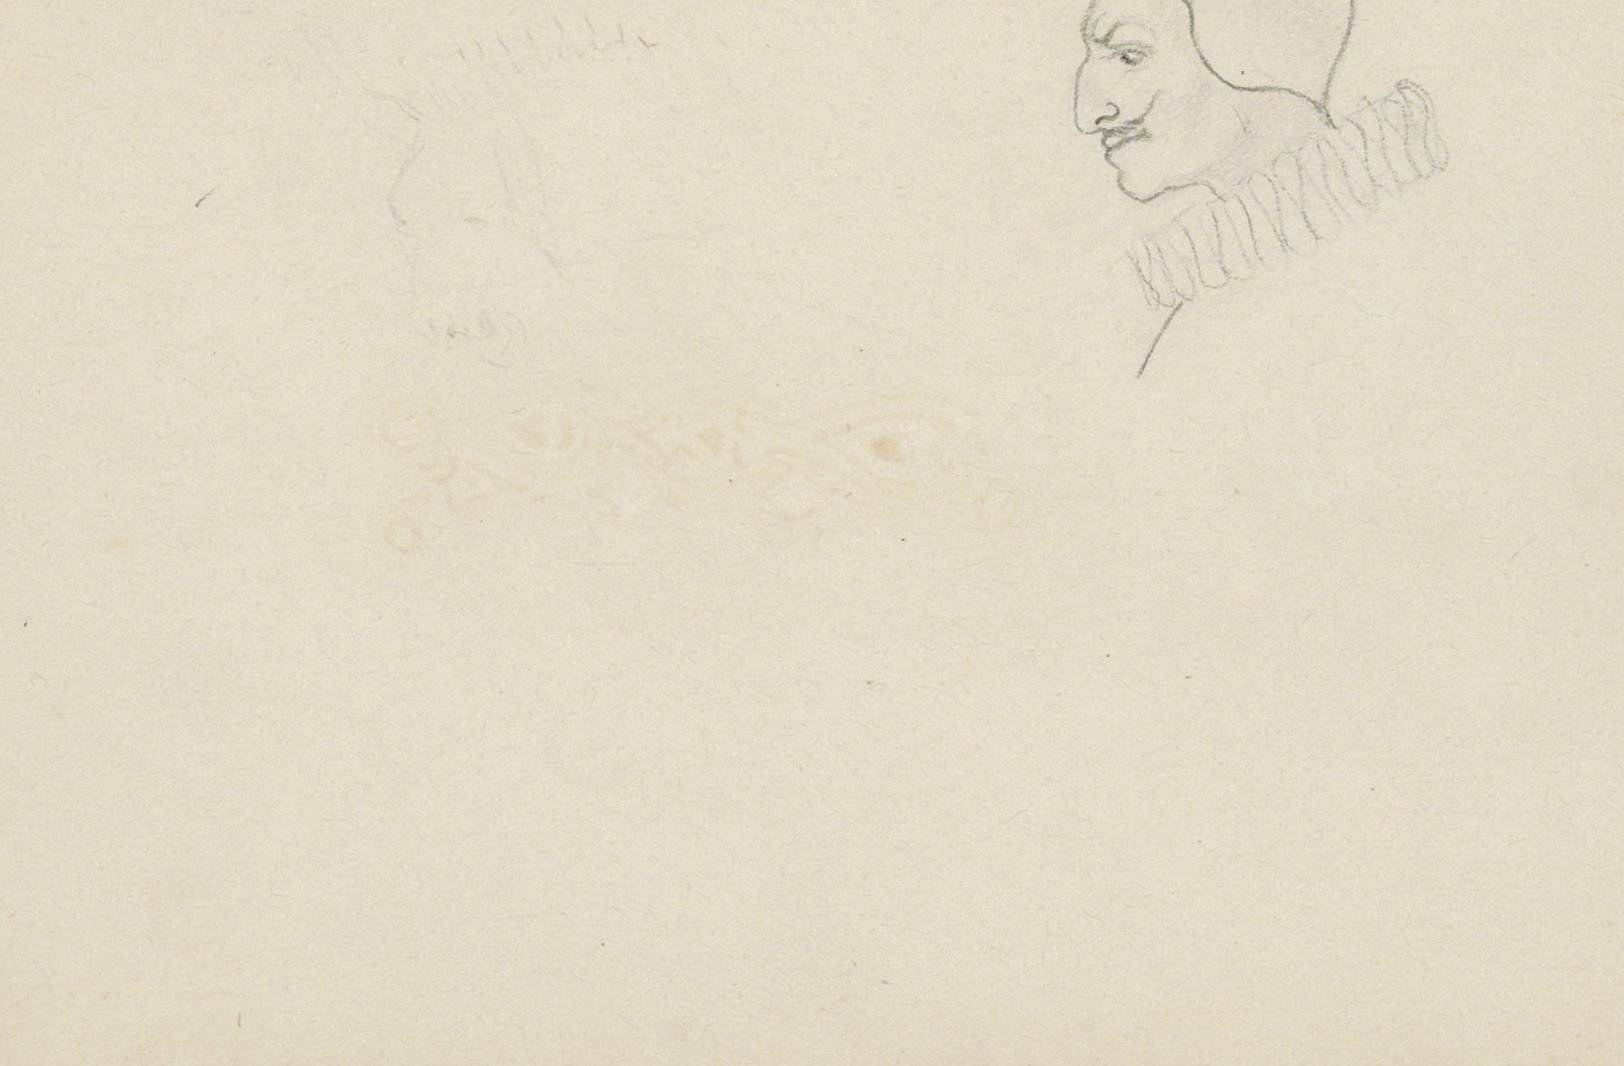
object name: sketchbook leaf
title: Man met een snor, muts en kanten kraag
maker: julie de graag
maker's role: draughtsman, print maker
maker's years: 1877-1924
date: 1894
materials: paper, pencil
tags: moustache, adult man, neck-gear: collar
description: Blad 8 recto uit een schetsboek met 35 bladen.